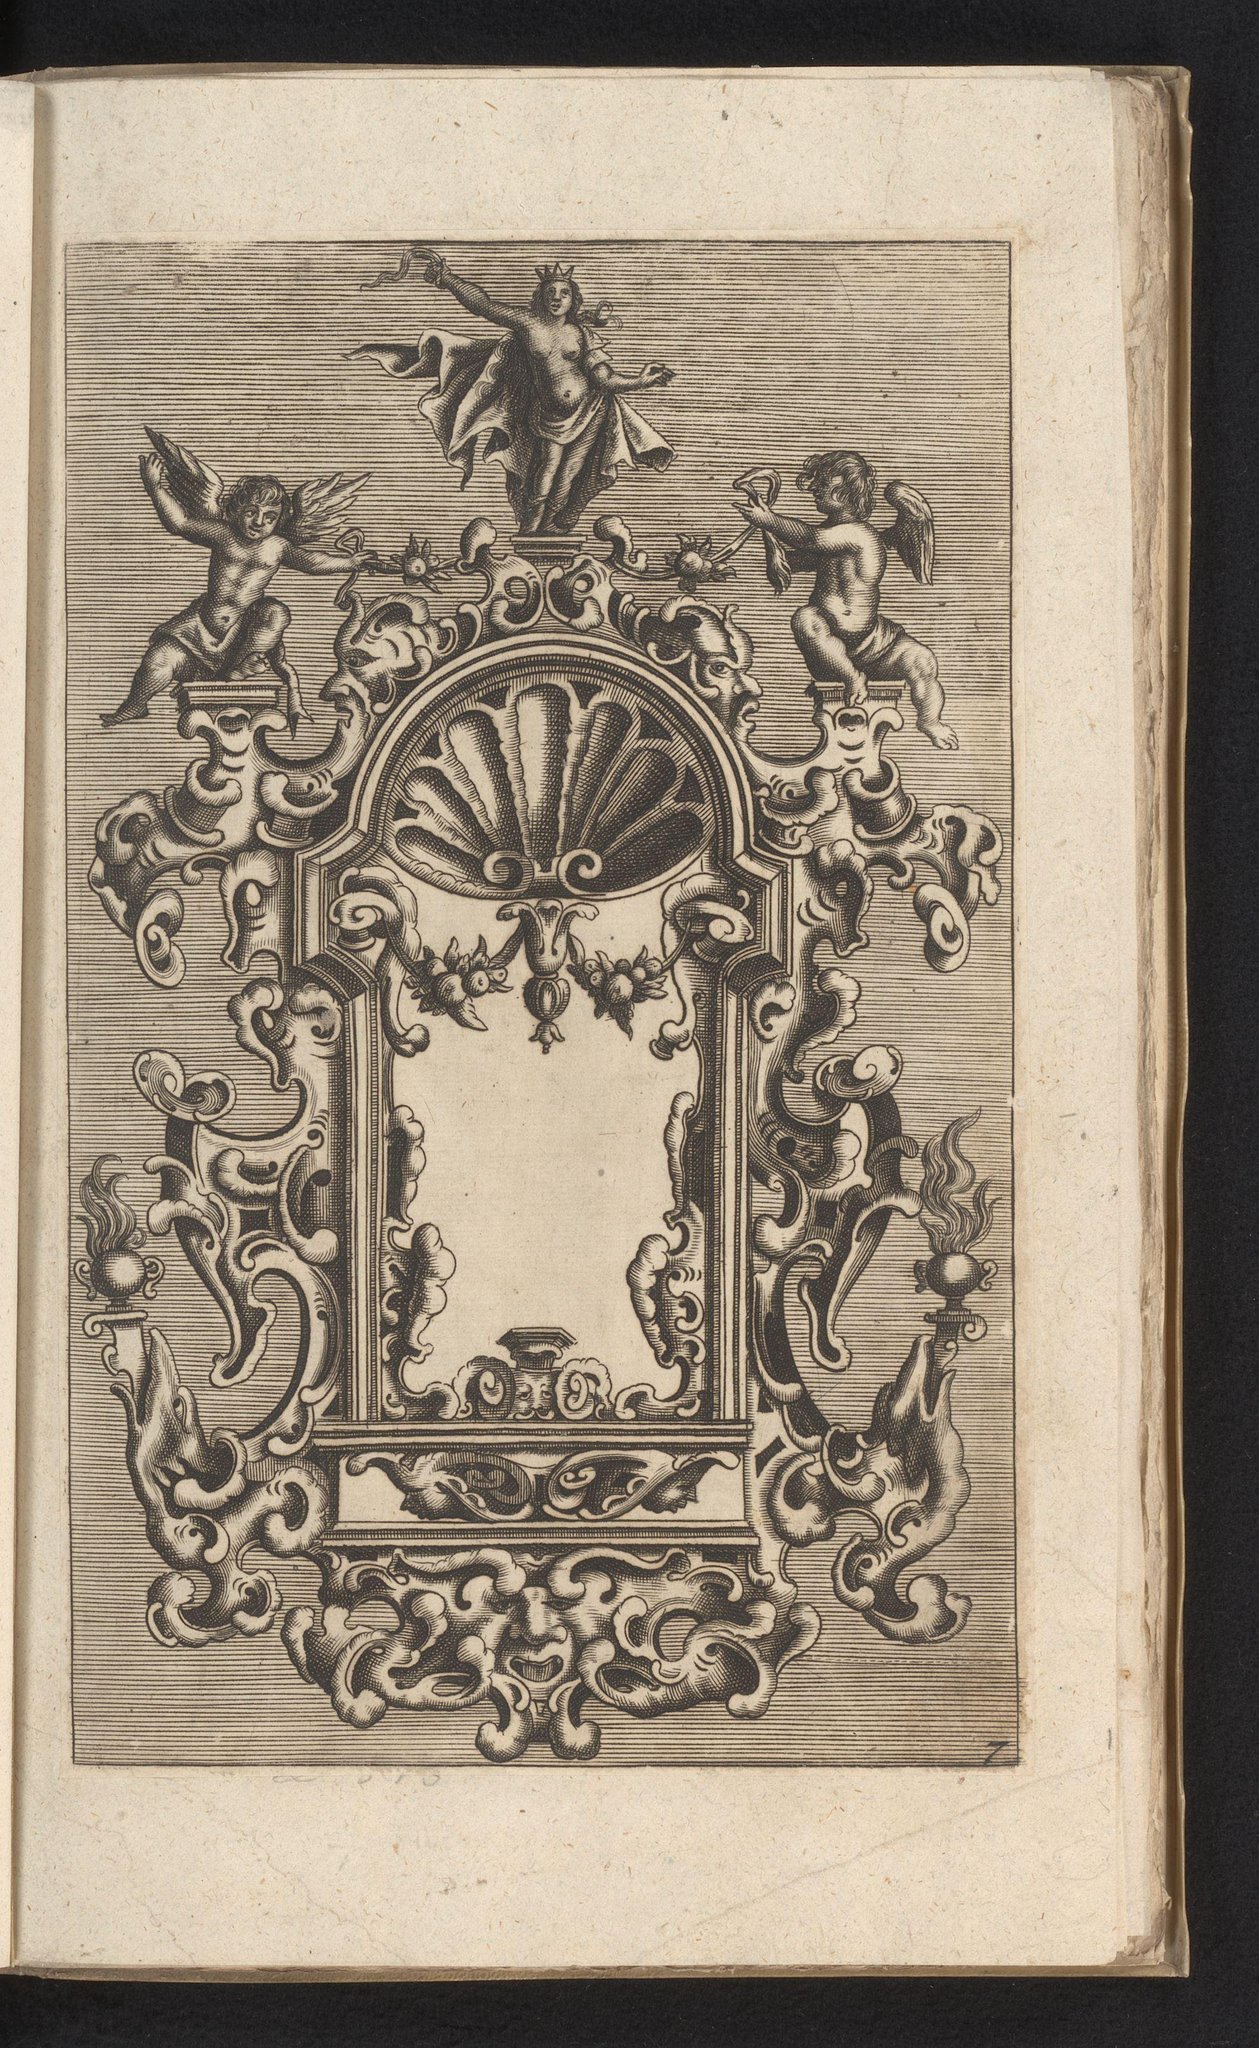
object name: album leaf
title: Neues Zierathen Buch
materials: paper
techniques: engraving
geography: nuremberg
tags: auricular ornament, lobe style ~ ornament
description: Deze prent maakt deel uit van een album.